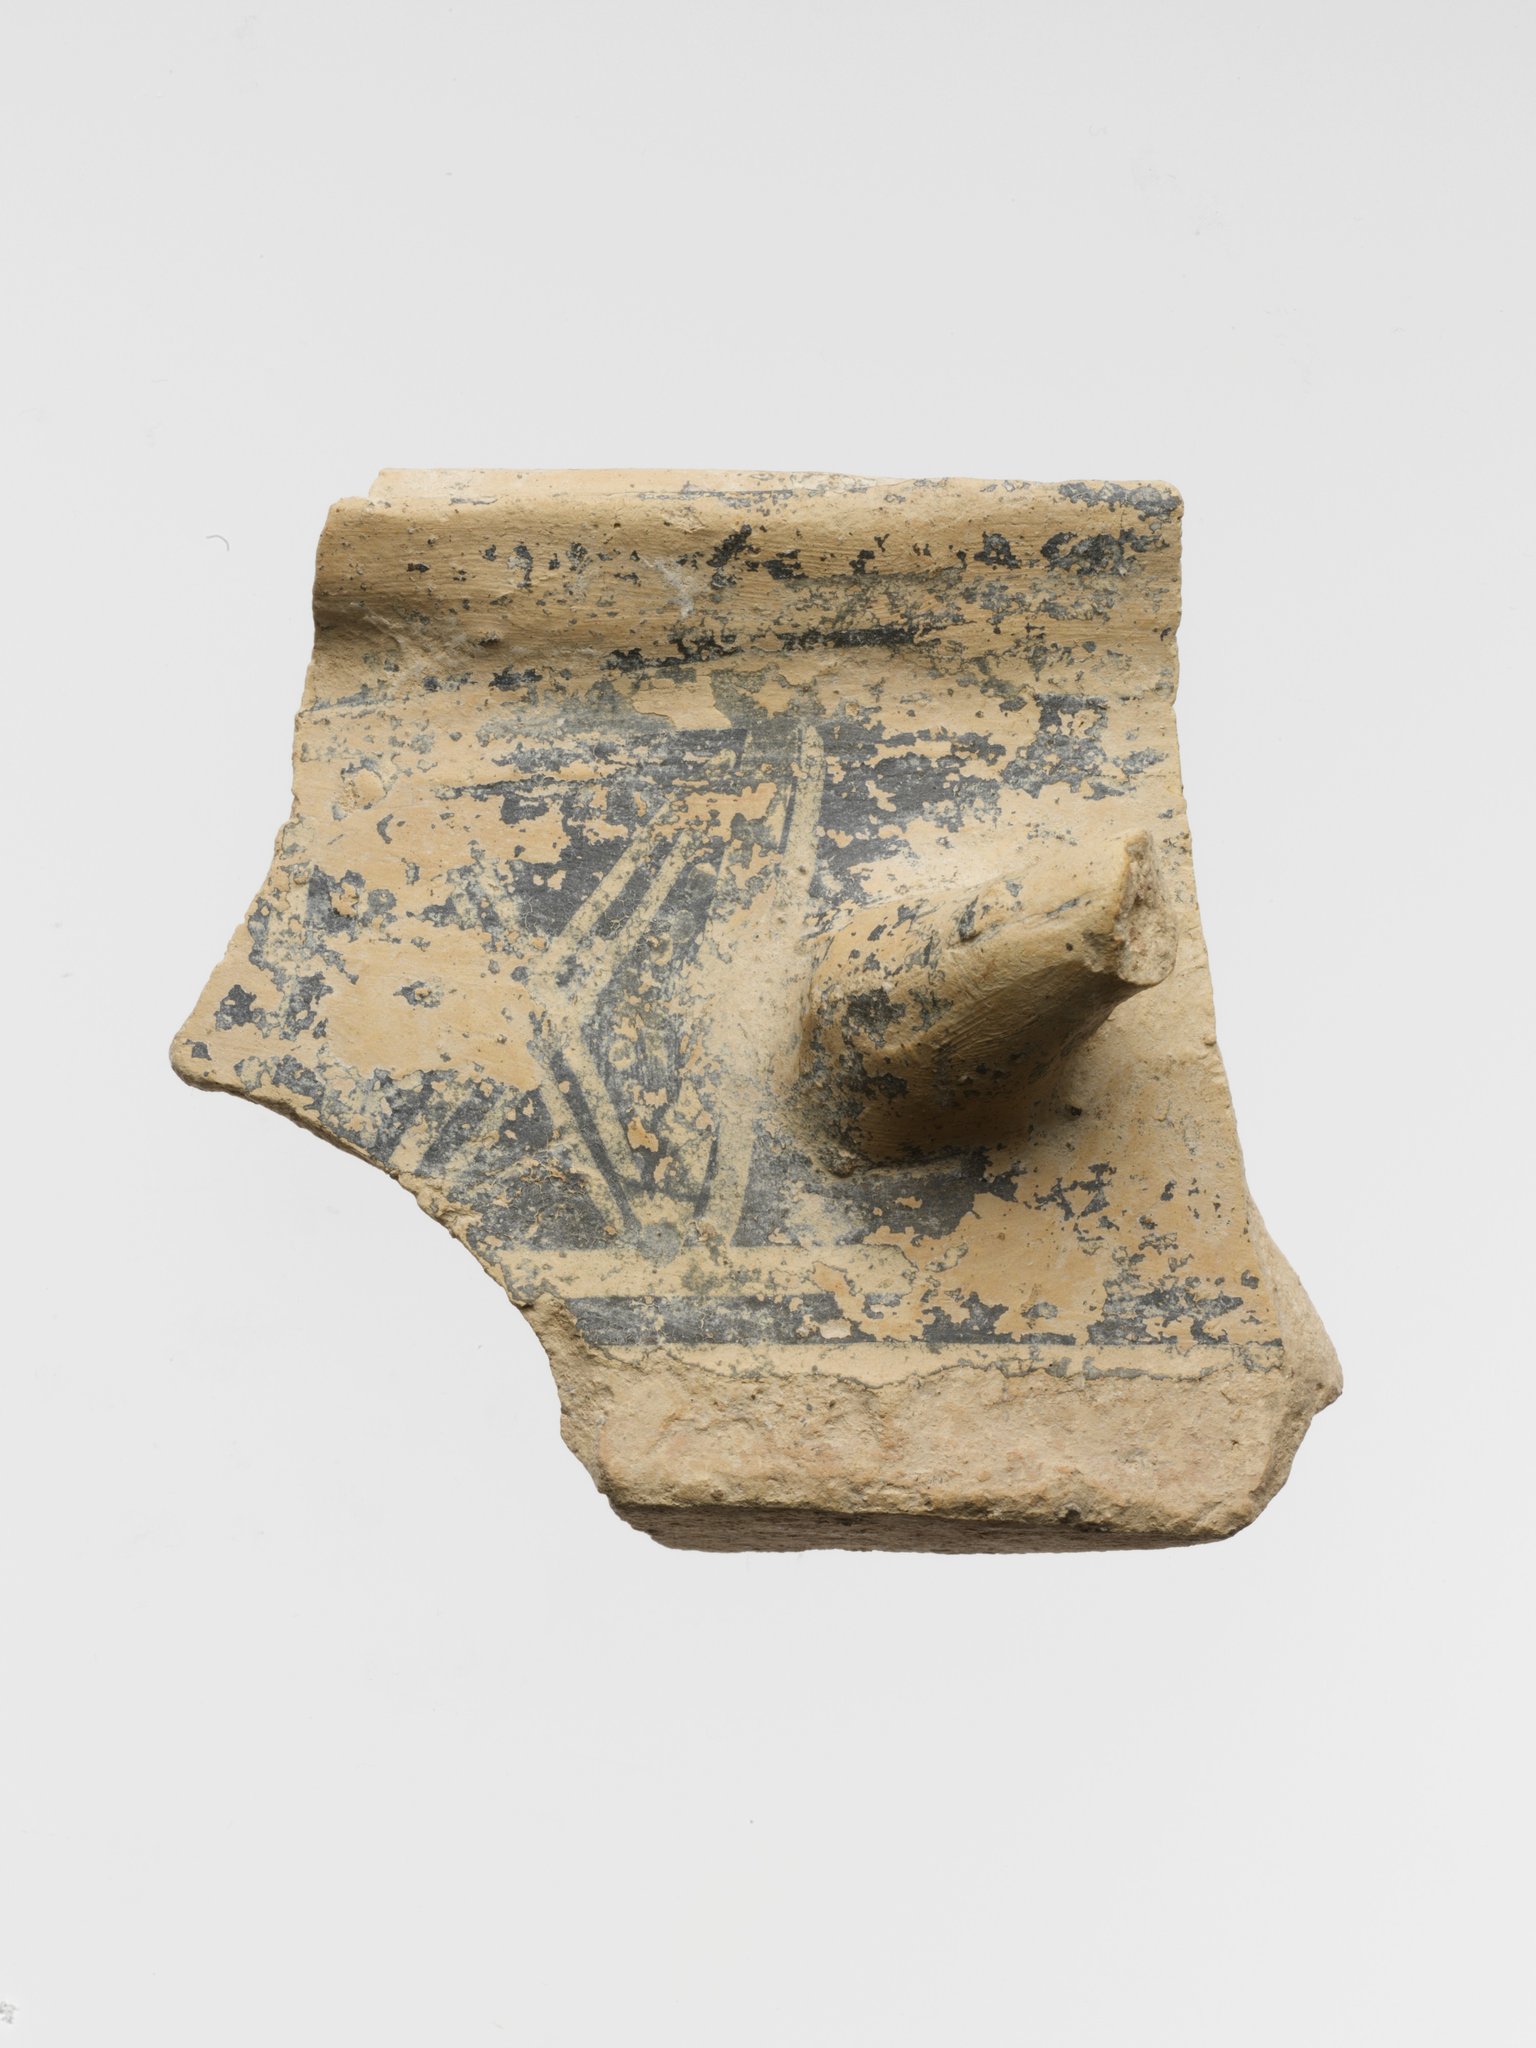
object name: vase fragment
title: Terracotta fragment of a cylindrical pyxis (box with lid) with part of handle and hatched squares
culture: minoan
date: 2300-2100 BCE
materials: terracotta